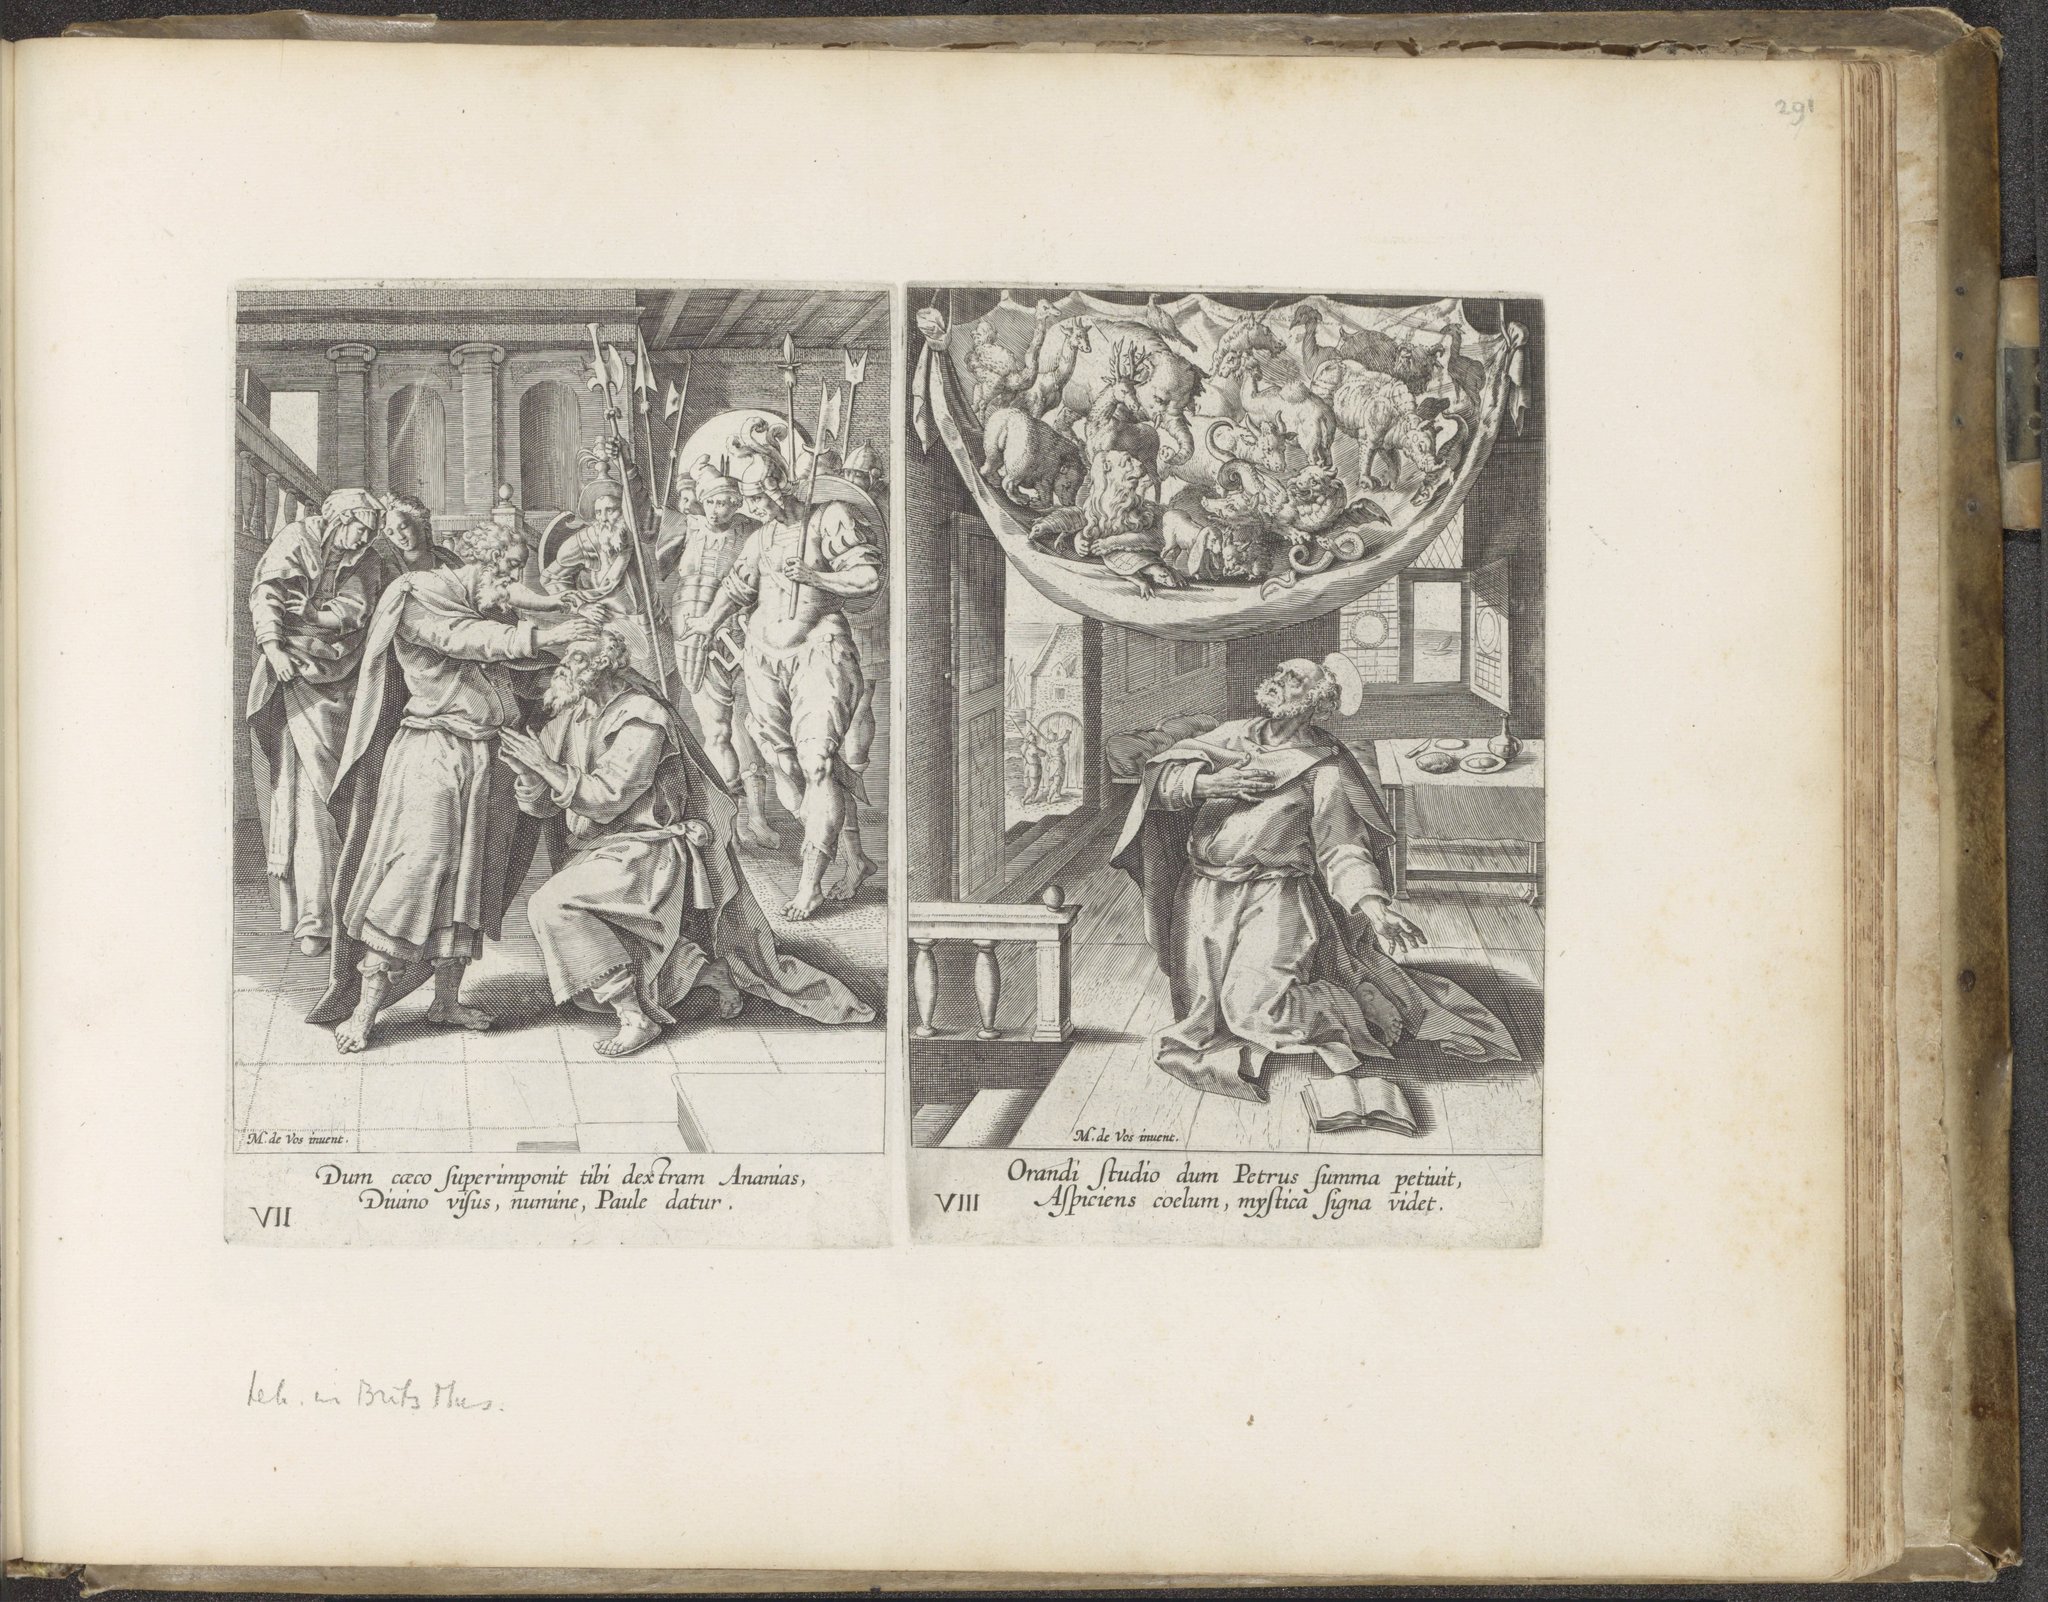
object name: album leaf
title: Ananias geneest de blindheid van Paulus / Petrus' visioen van de onreine dieren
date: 1591-1600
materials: paper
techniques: engraving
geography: amsterdam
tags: ananias restores saul's sight by laying on hands, peter's vision of the unclean beasts on the roof of the house of simon the tanner: a sheet descends from heaven full of four-footed beasts, creeping things and fowl of the air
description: Twee voorstellingen op een albumblad. Links staat Ananias voor de knielende Paulus en geneest hem door handoplegging van zijn blindheid. Rechts bidt Petrus in het huis van Simon de leerlooier. Boven hem een laken met allerlei onreine diersoorten. Hij kreeg drie keer het bevel om de dieren te slachten en op te eten, maar dat weigerde hij. Onder beide voorstellingen een tweeregelig onderschrift in het Latijn. Het blad maakt deel uit van een album.